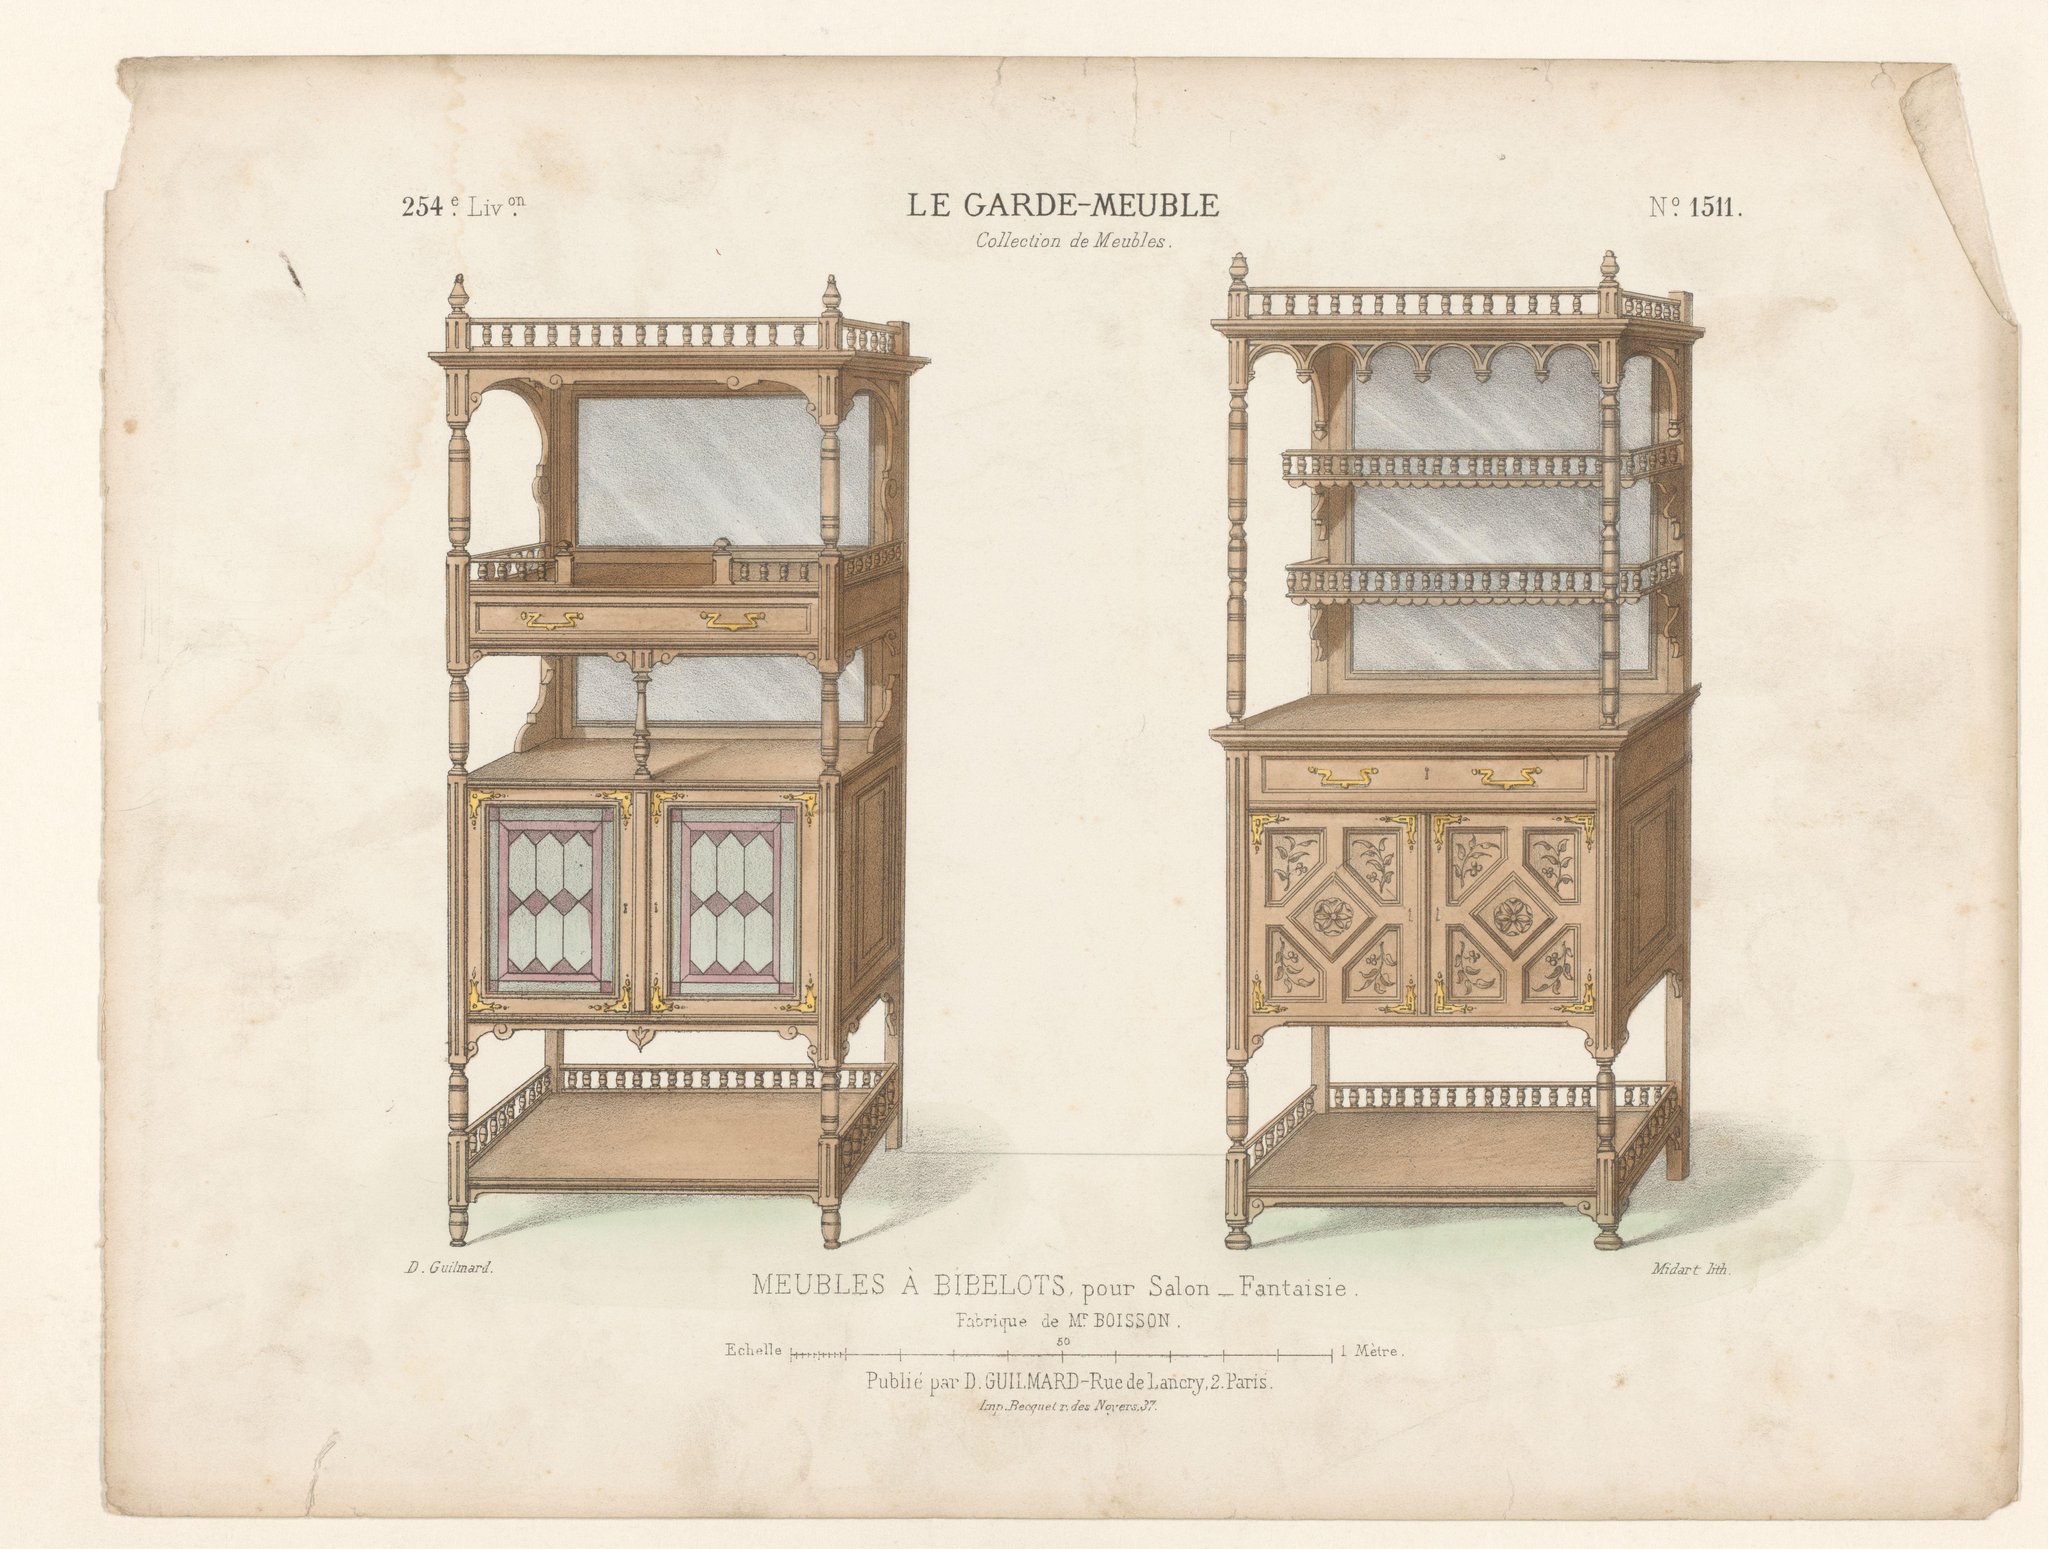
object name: print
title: Le garde-meuble / Collection de Meubles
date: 1839-1885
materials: paper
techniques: hand coloring, lithograph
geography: paris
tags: furniture for storage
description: Ieder Livraison in de serie Le Garde-Meuble bevat negen platen: drie 'sièges' (zitmeubels), drie 'meubles' (diverse meubels zoals tafels en kasten) en drie 'tentures' (gordijnen en draperieën).